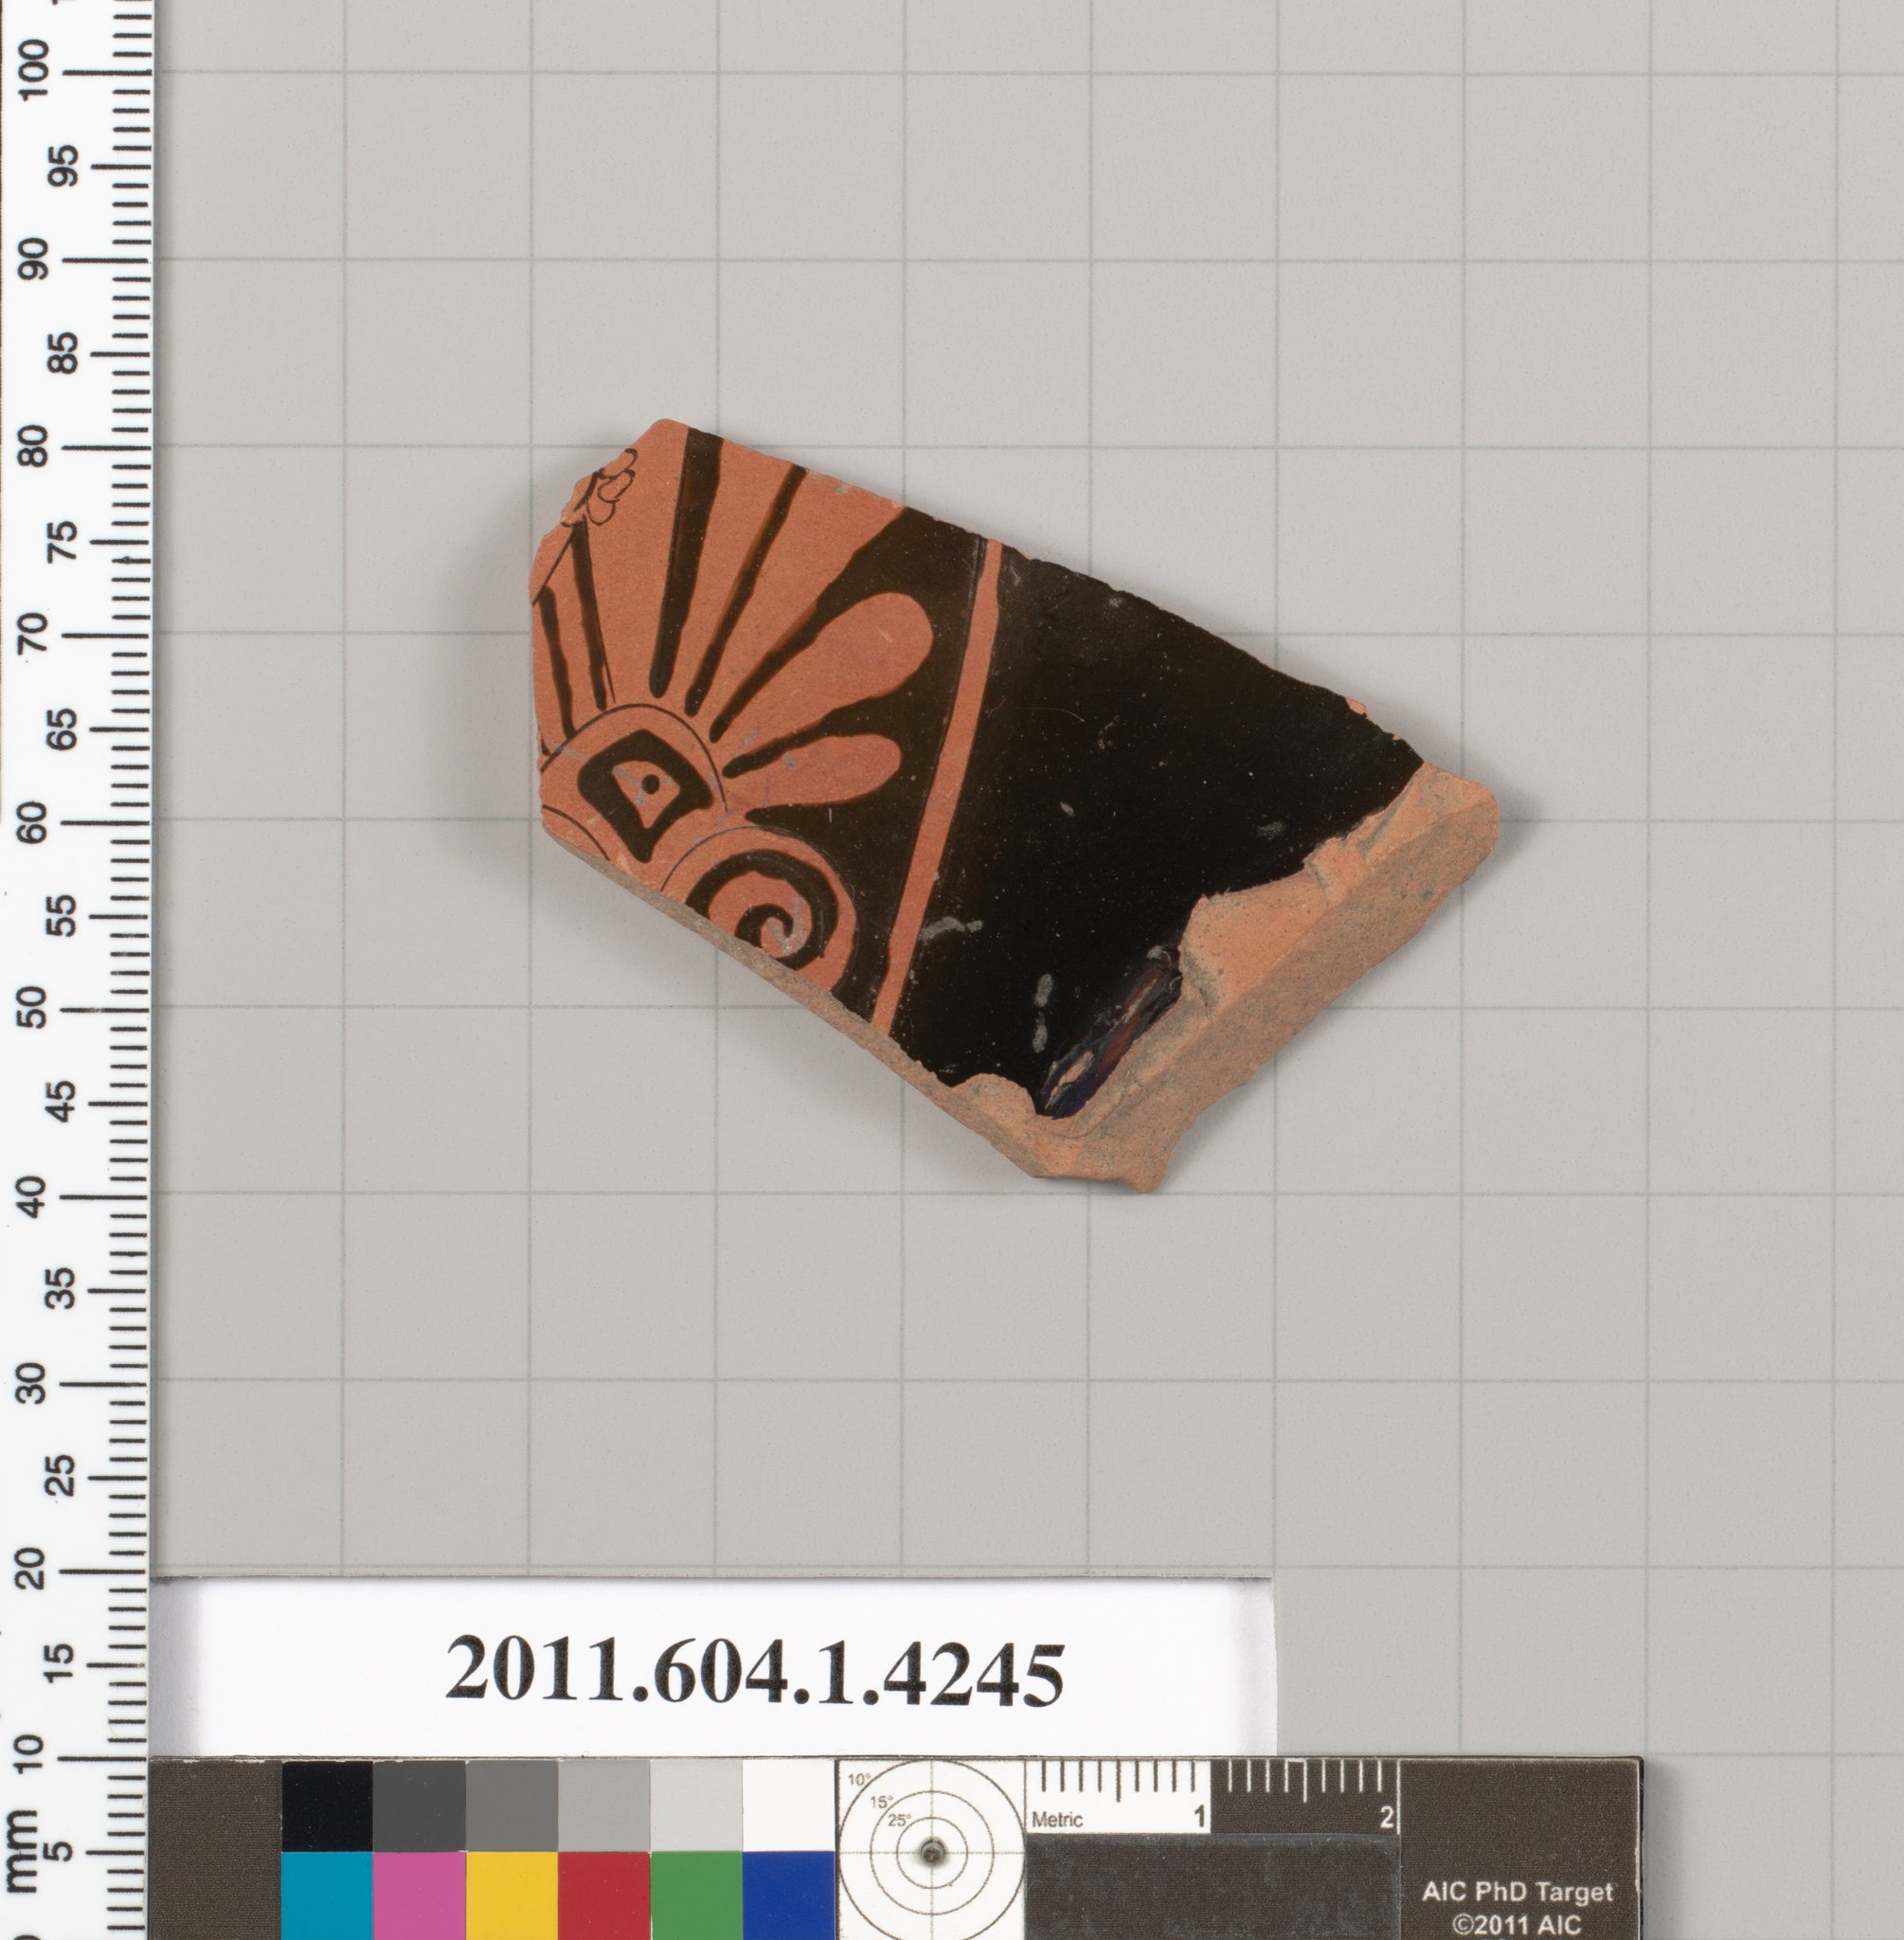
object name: kylix fragment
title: Terracotta fragment of a kylix (drinking cup)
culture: greek, attic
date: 475-451 BCE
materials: terracotta